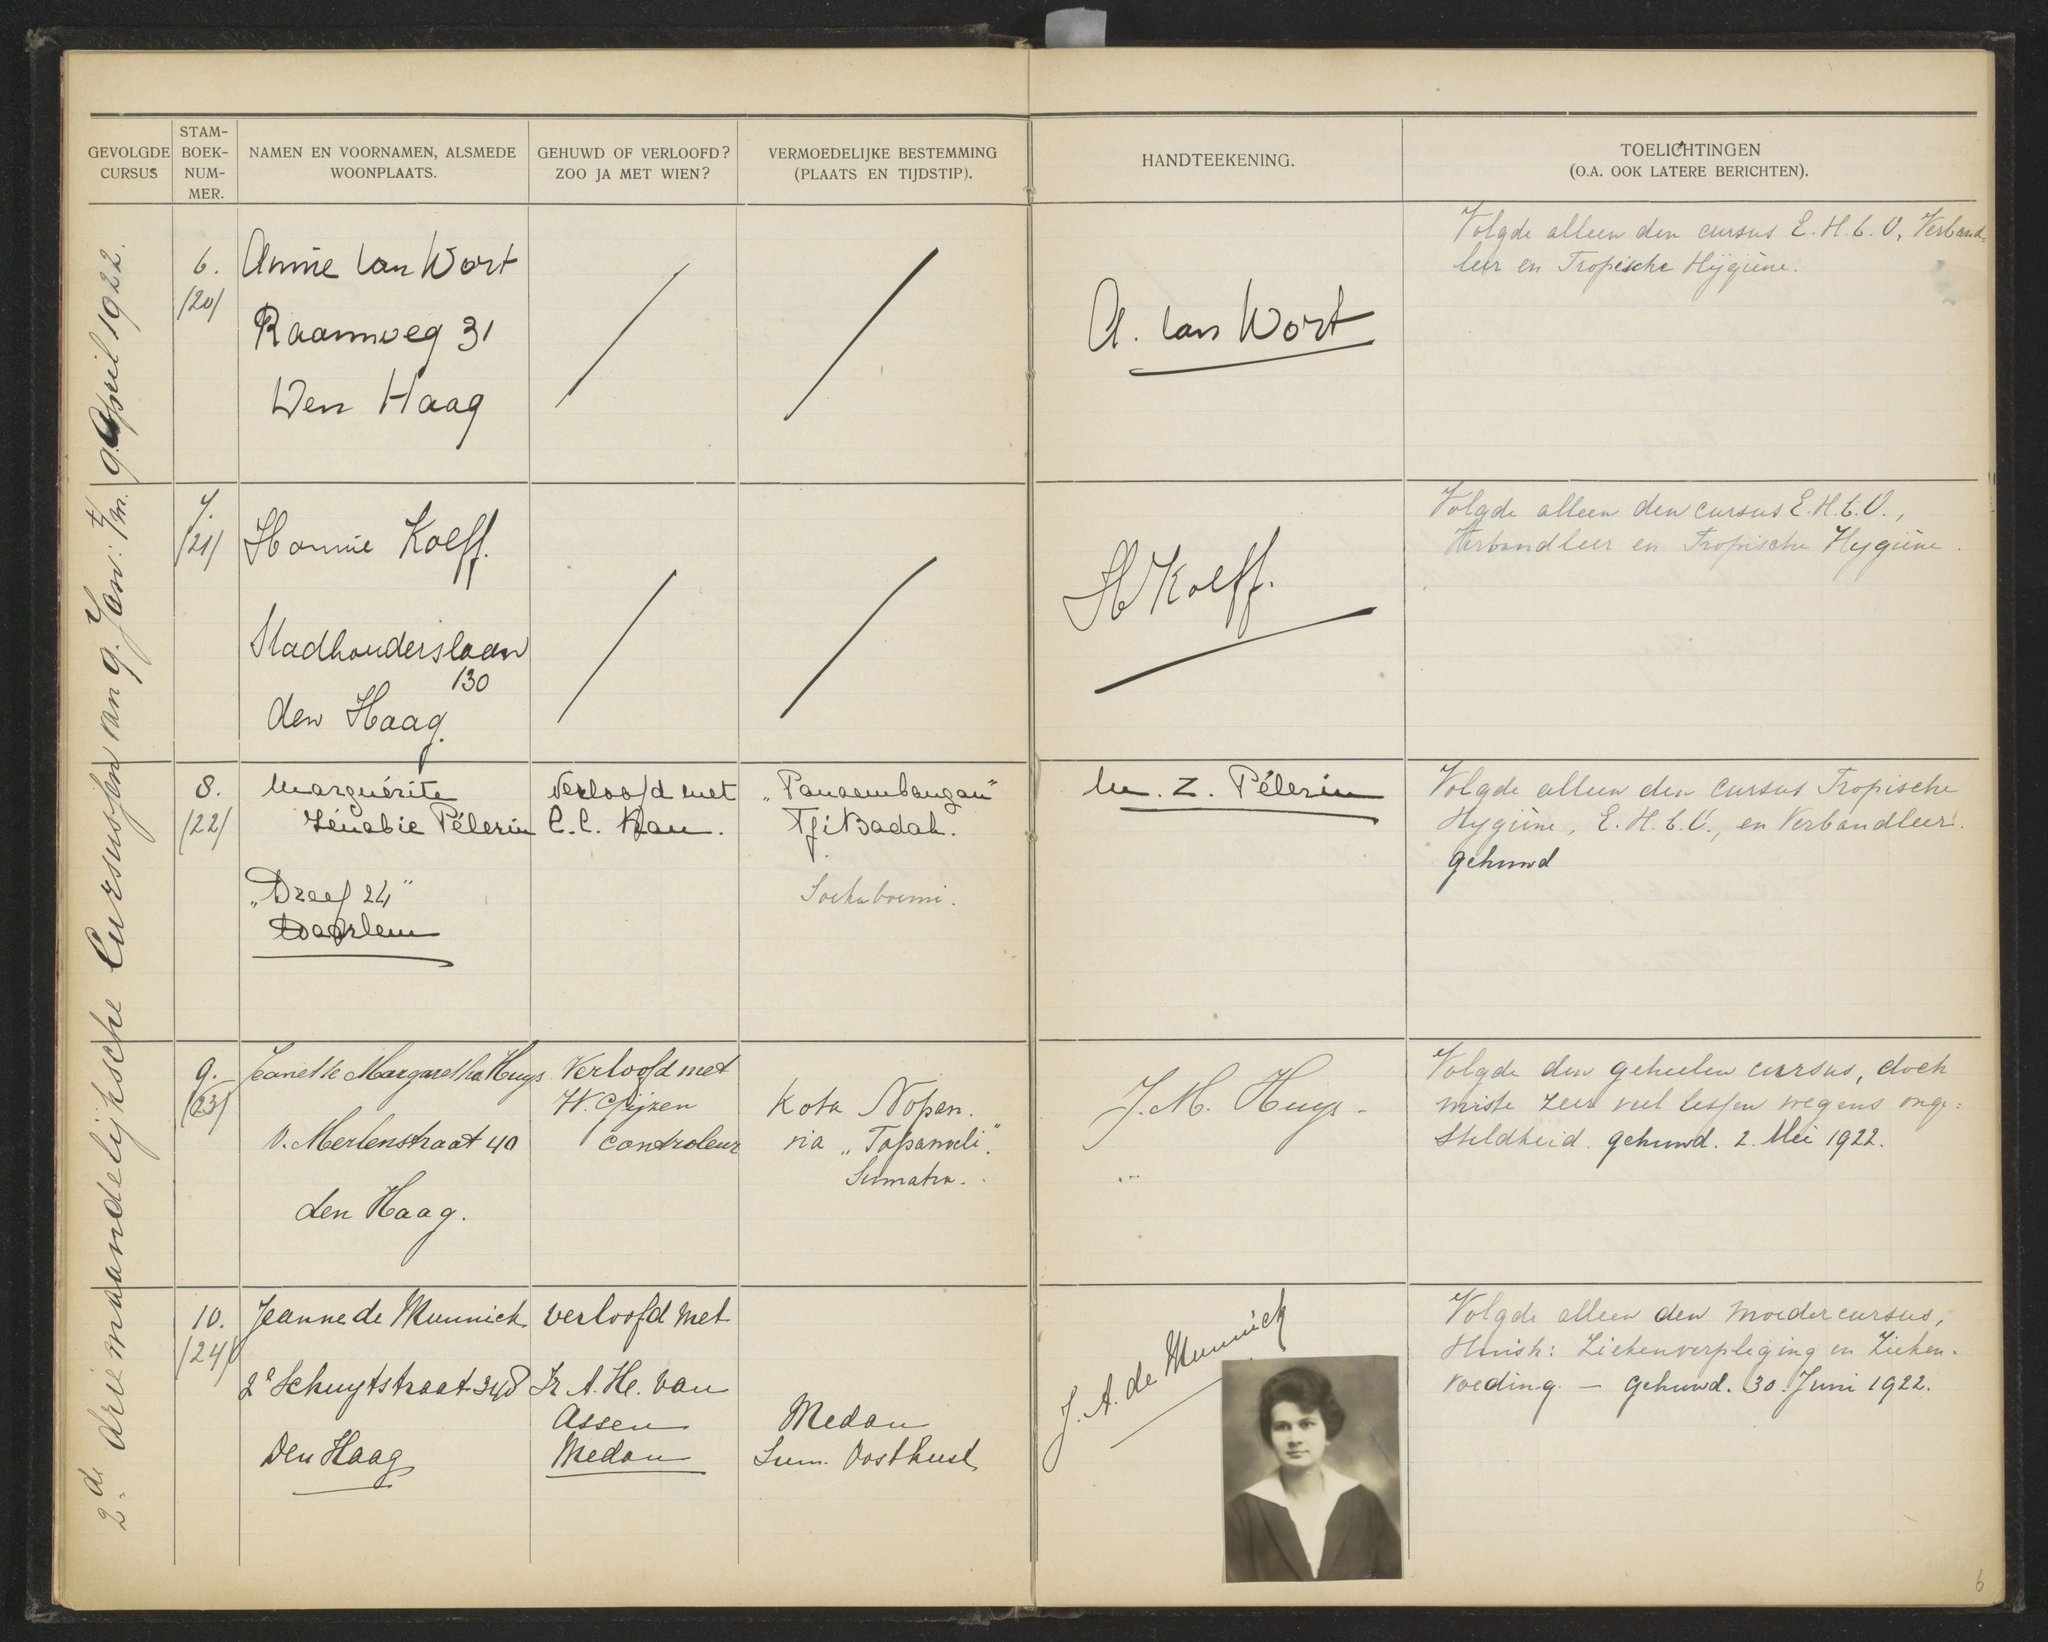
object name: album leaf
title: Blad 6 uit Stamboek van de leerlingen der Koloniale School voor Meisjes en Vrouwen te 's-Gravenhage deel I (1921-1929)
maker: Anonymous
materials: paper, photographic support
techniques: photography, printing, writing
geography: the hague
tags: further education (+ pupil), further education, the hague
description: Twee pagina's met gegevens van de deelnemers aan de 2e driemaandelijkse cursus van 9 januari tot en met 9 april 1922, stamboeknummers 20 tot en met 24. Onderdeel van Stamboek van de leerlingen der Koloniale School voor Meisjes en Vrouwen te 's-Gravenhage deel I (1921-1929).